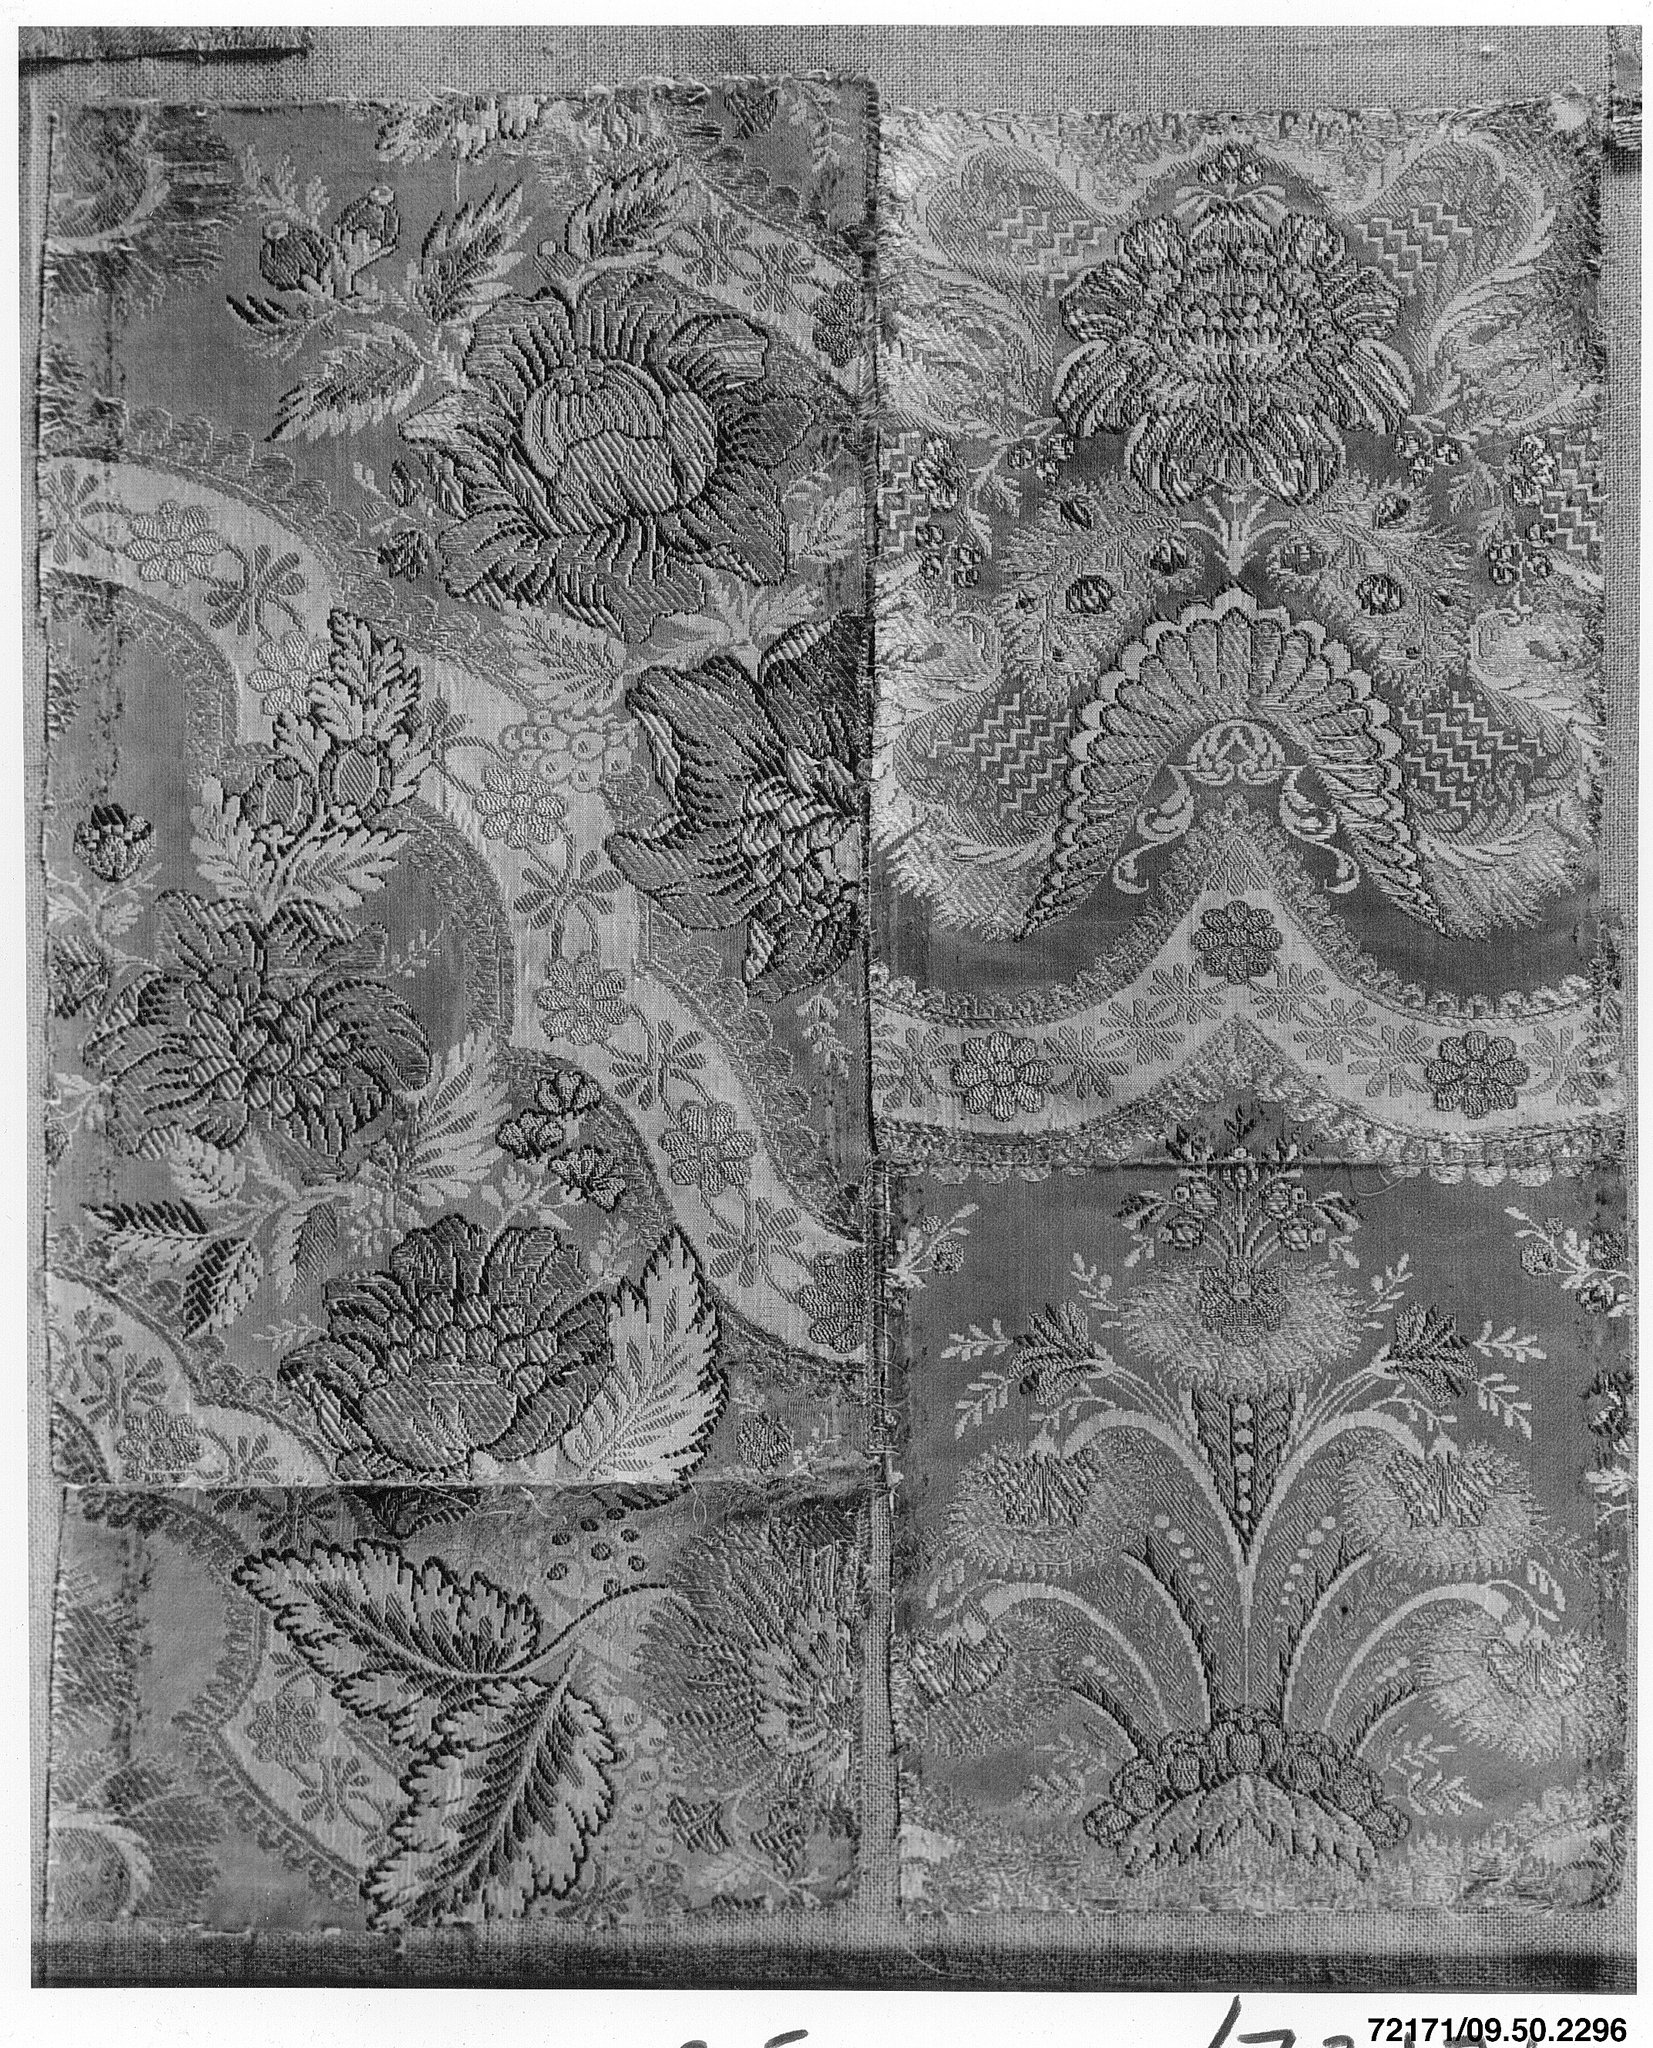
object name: piece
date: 1720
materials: metal thread, silk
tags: leaves